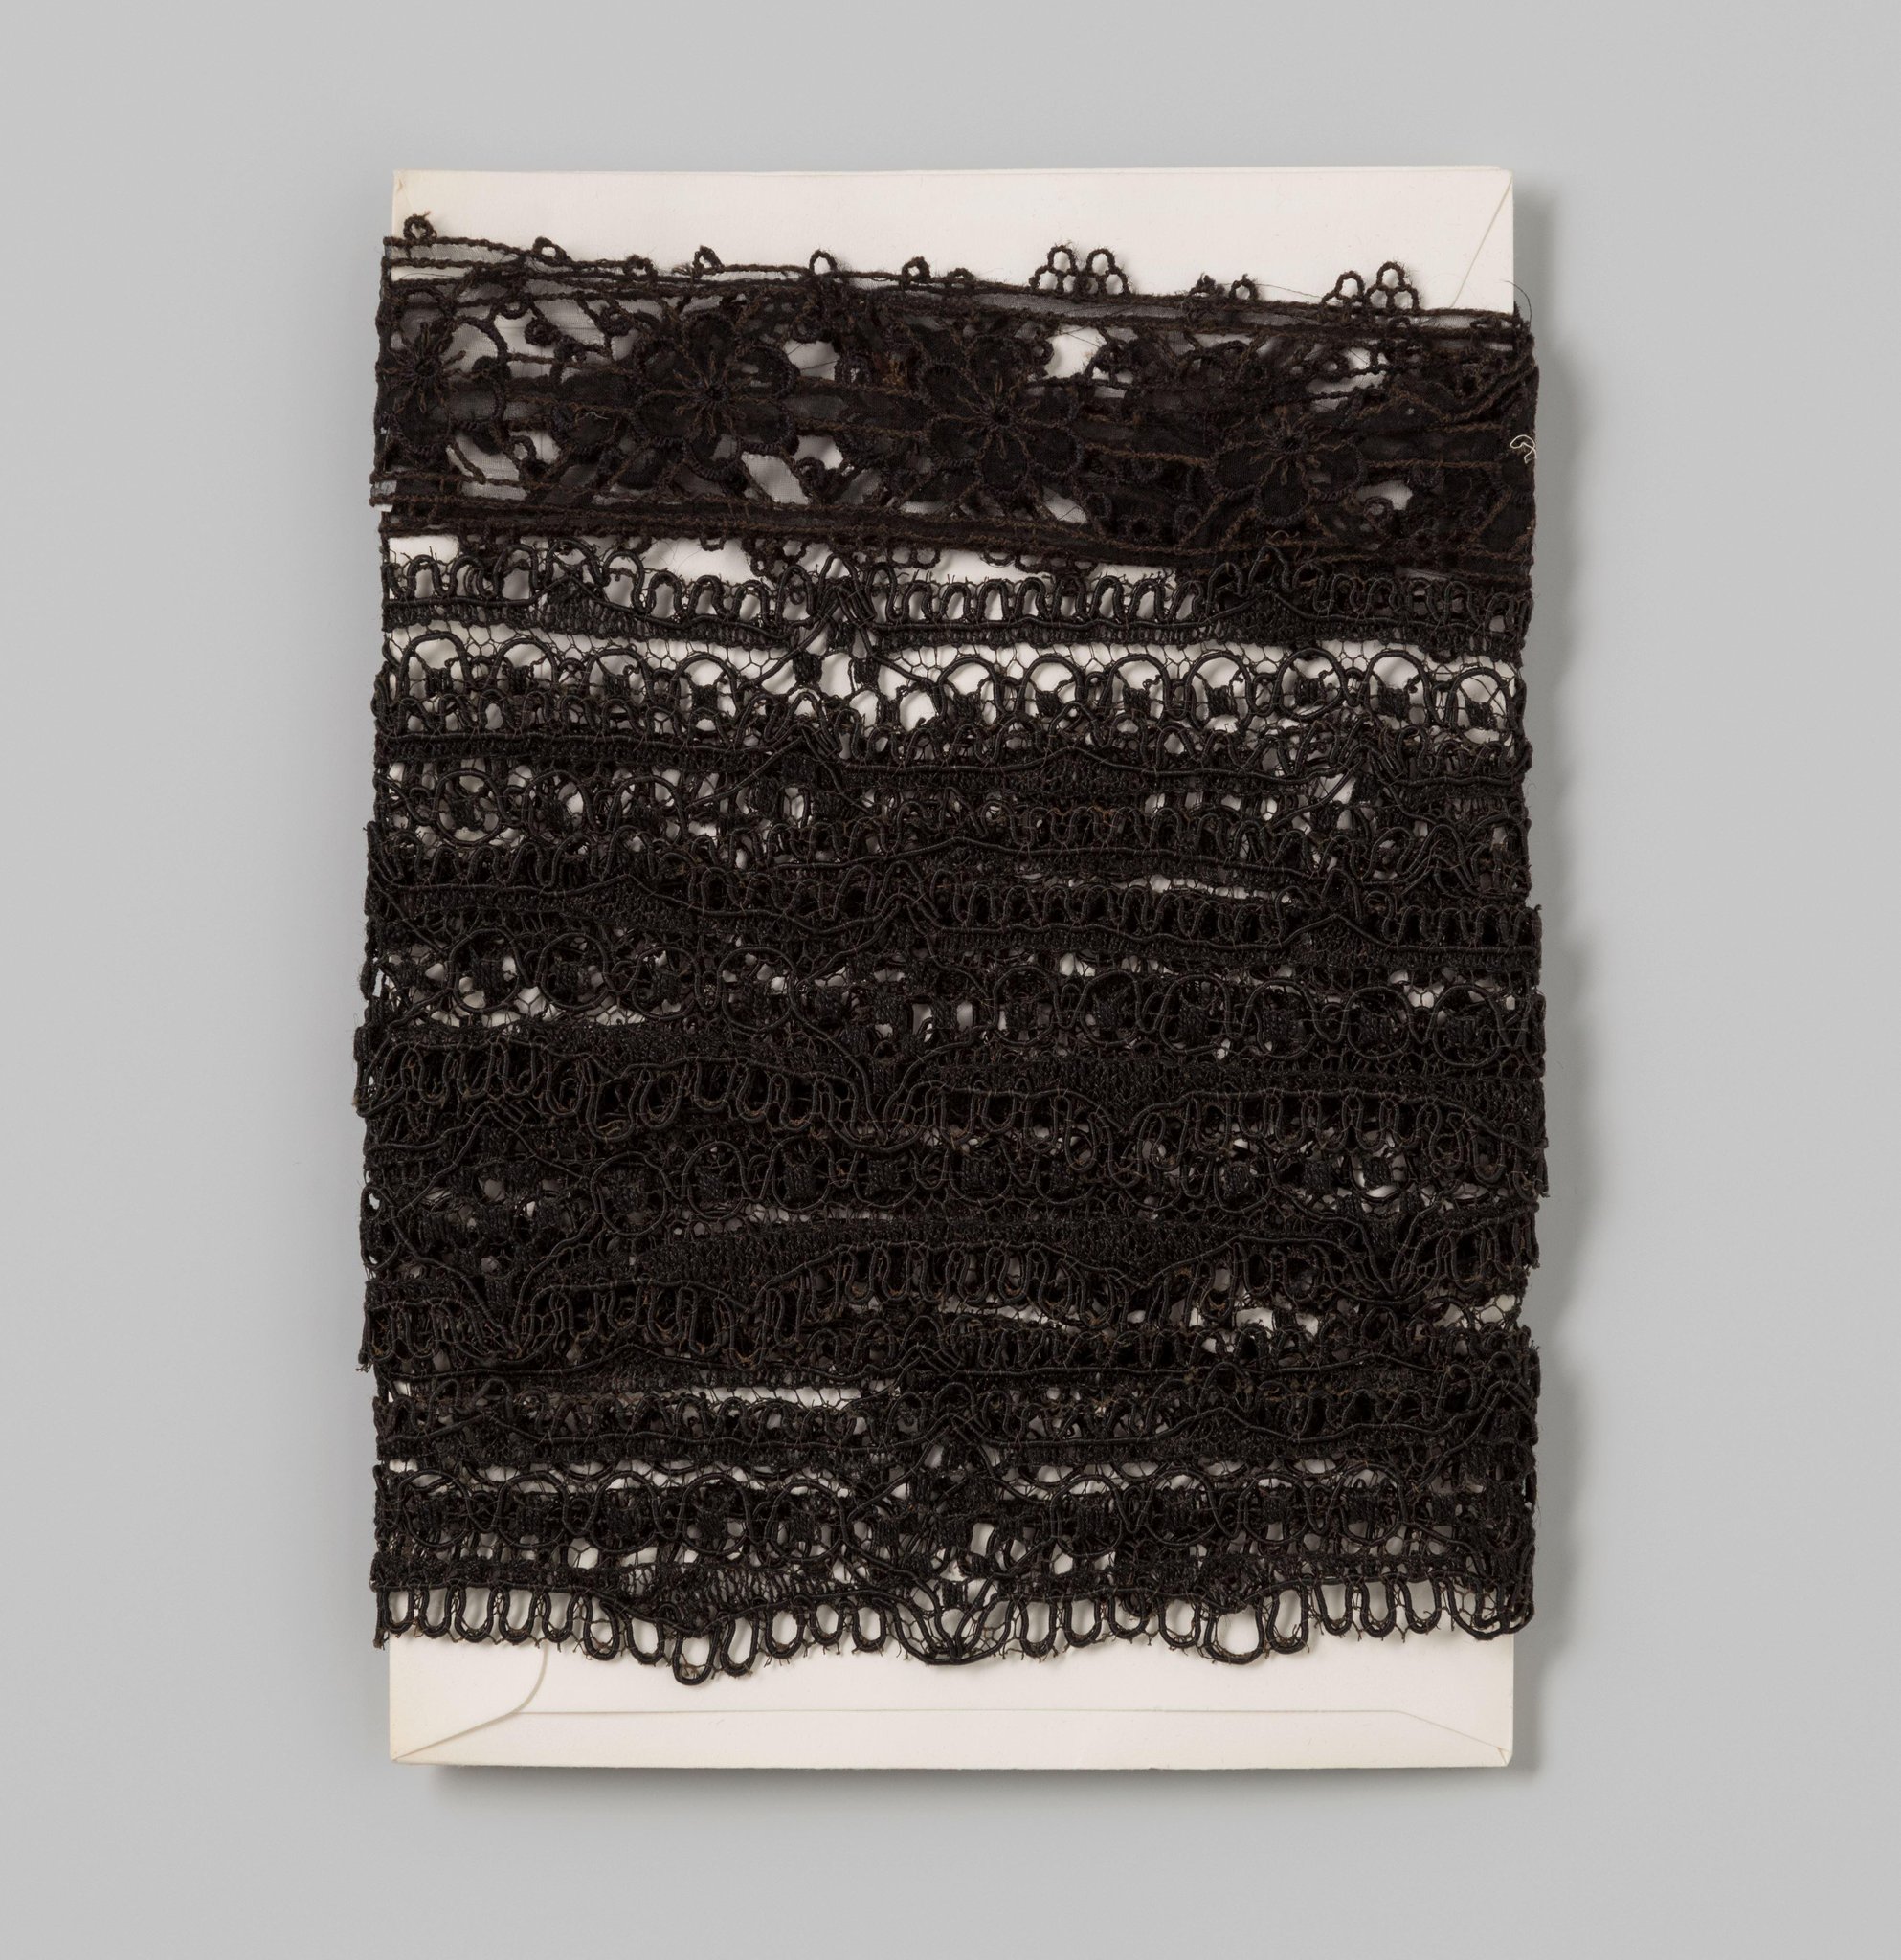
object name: galloon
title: Galon, zwart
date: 1920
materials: galloon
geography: france